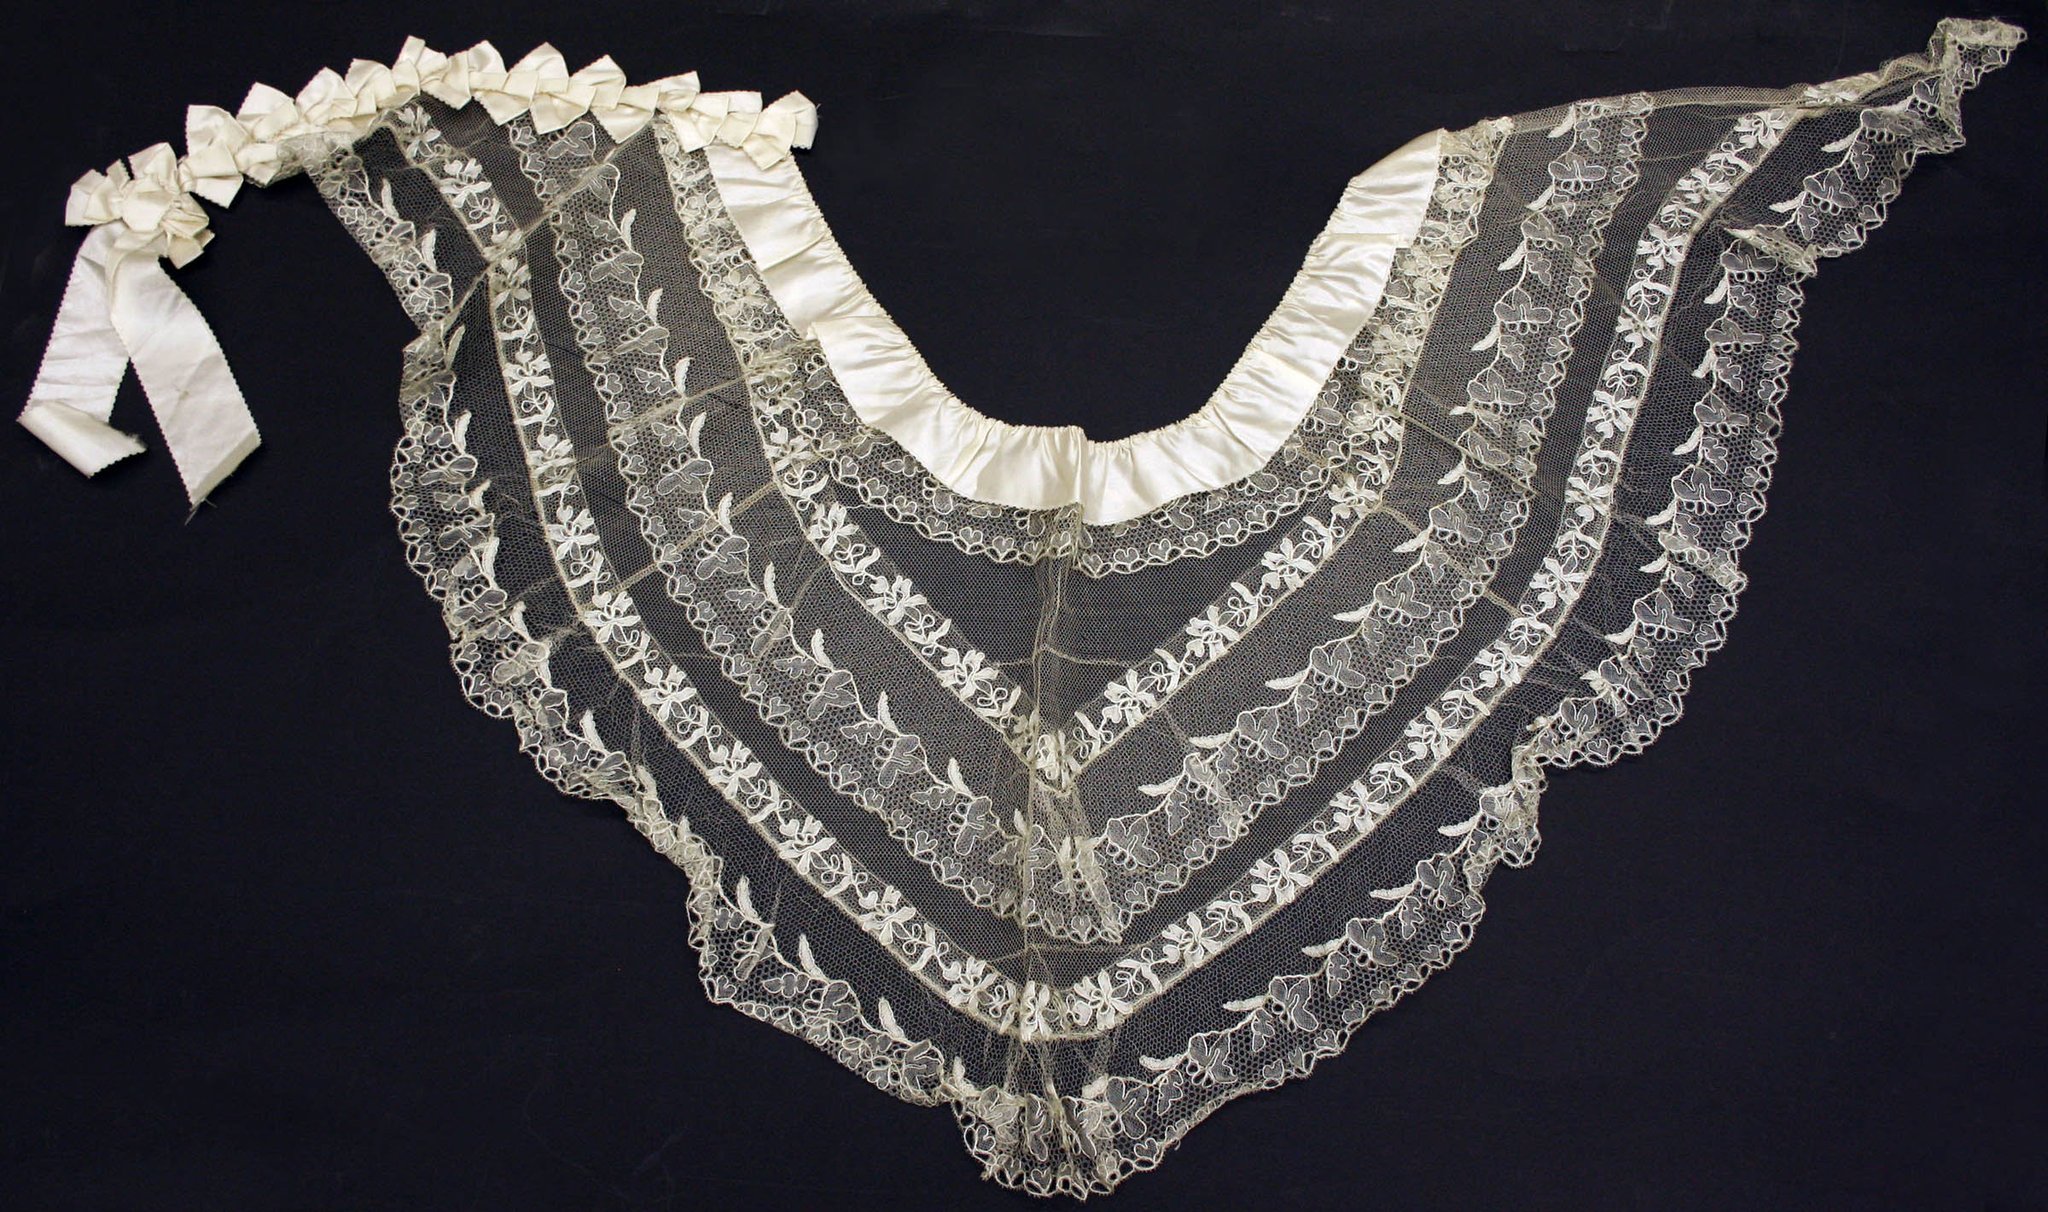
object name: fichu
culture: european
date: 1845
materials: silk